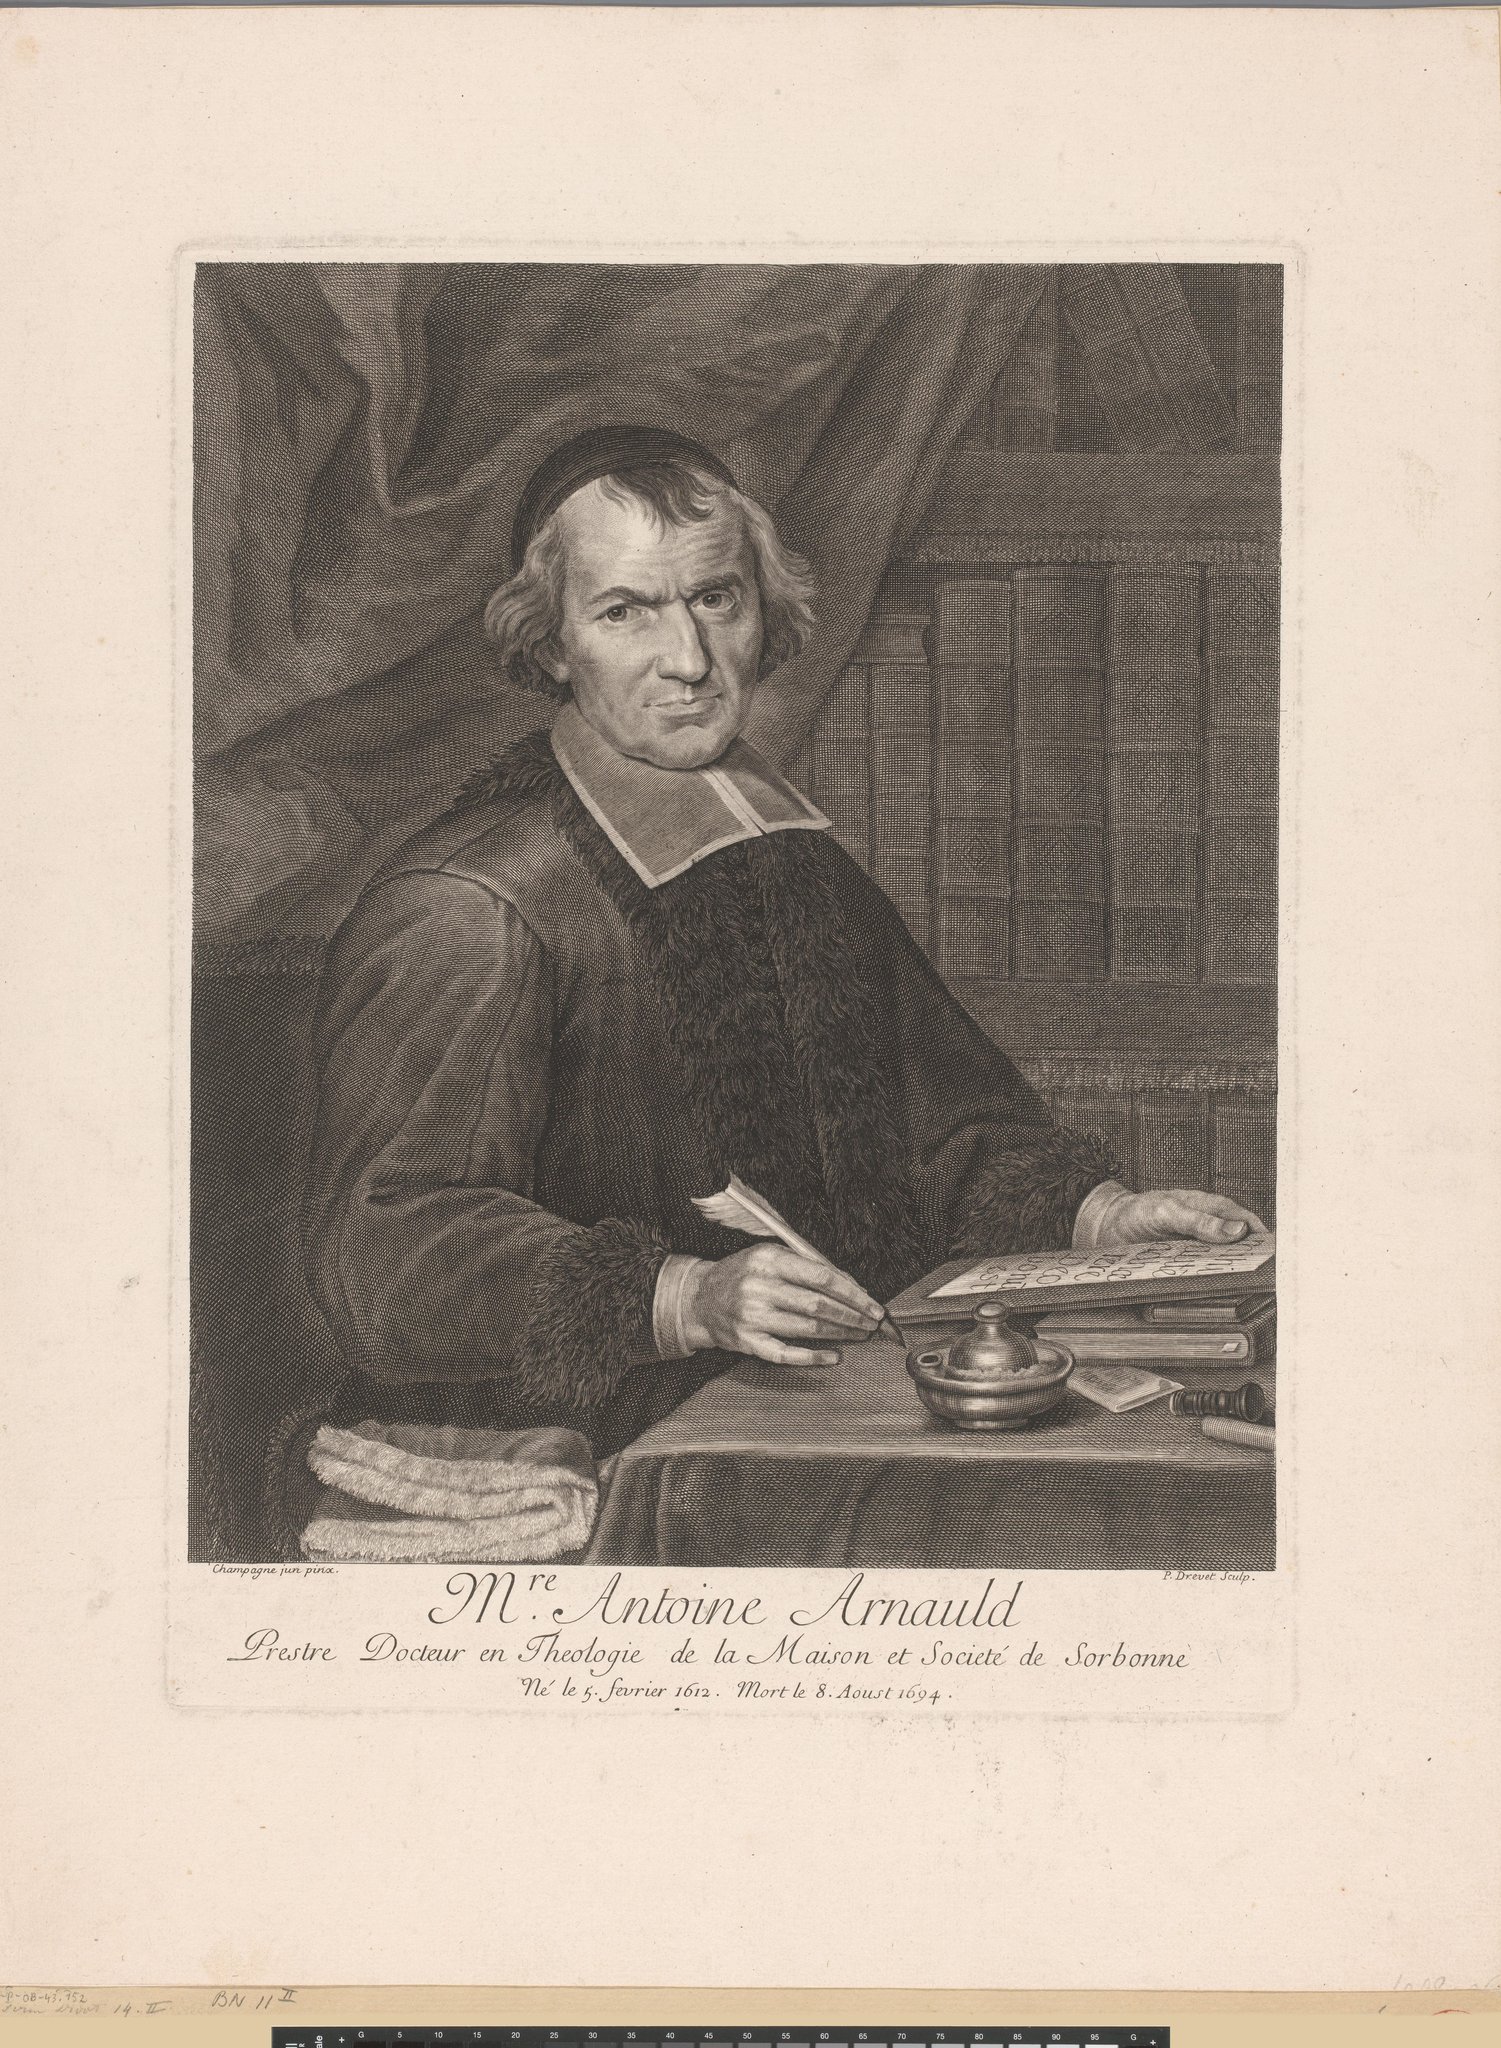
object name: print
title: Mre. Antoine Arnauld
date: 1696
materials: paper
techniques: engraving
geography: france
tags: writing-table, writing-desk, theologian, historical persons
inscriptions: collector's mark: Lugt 240